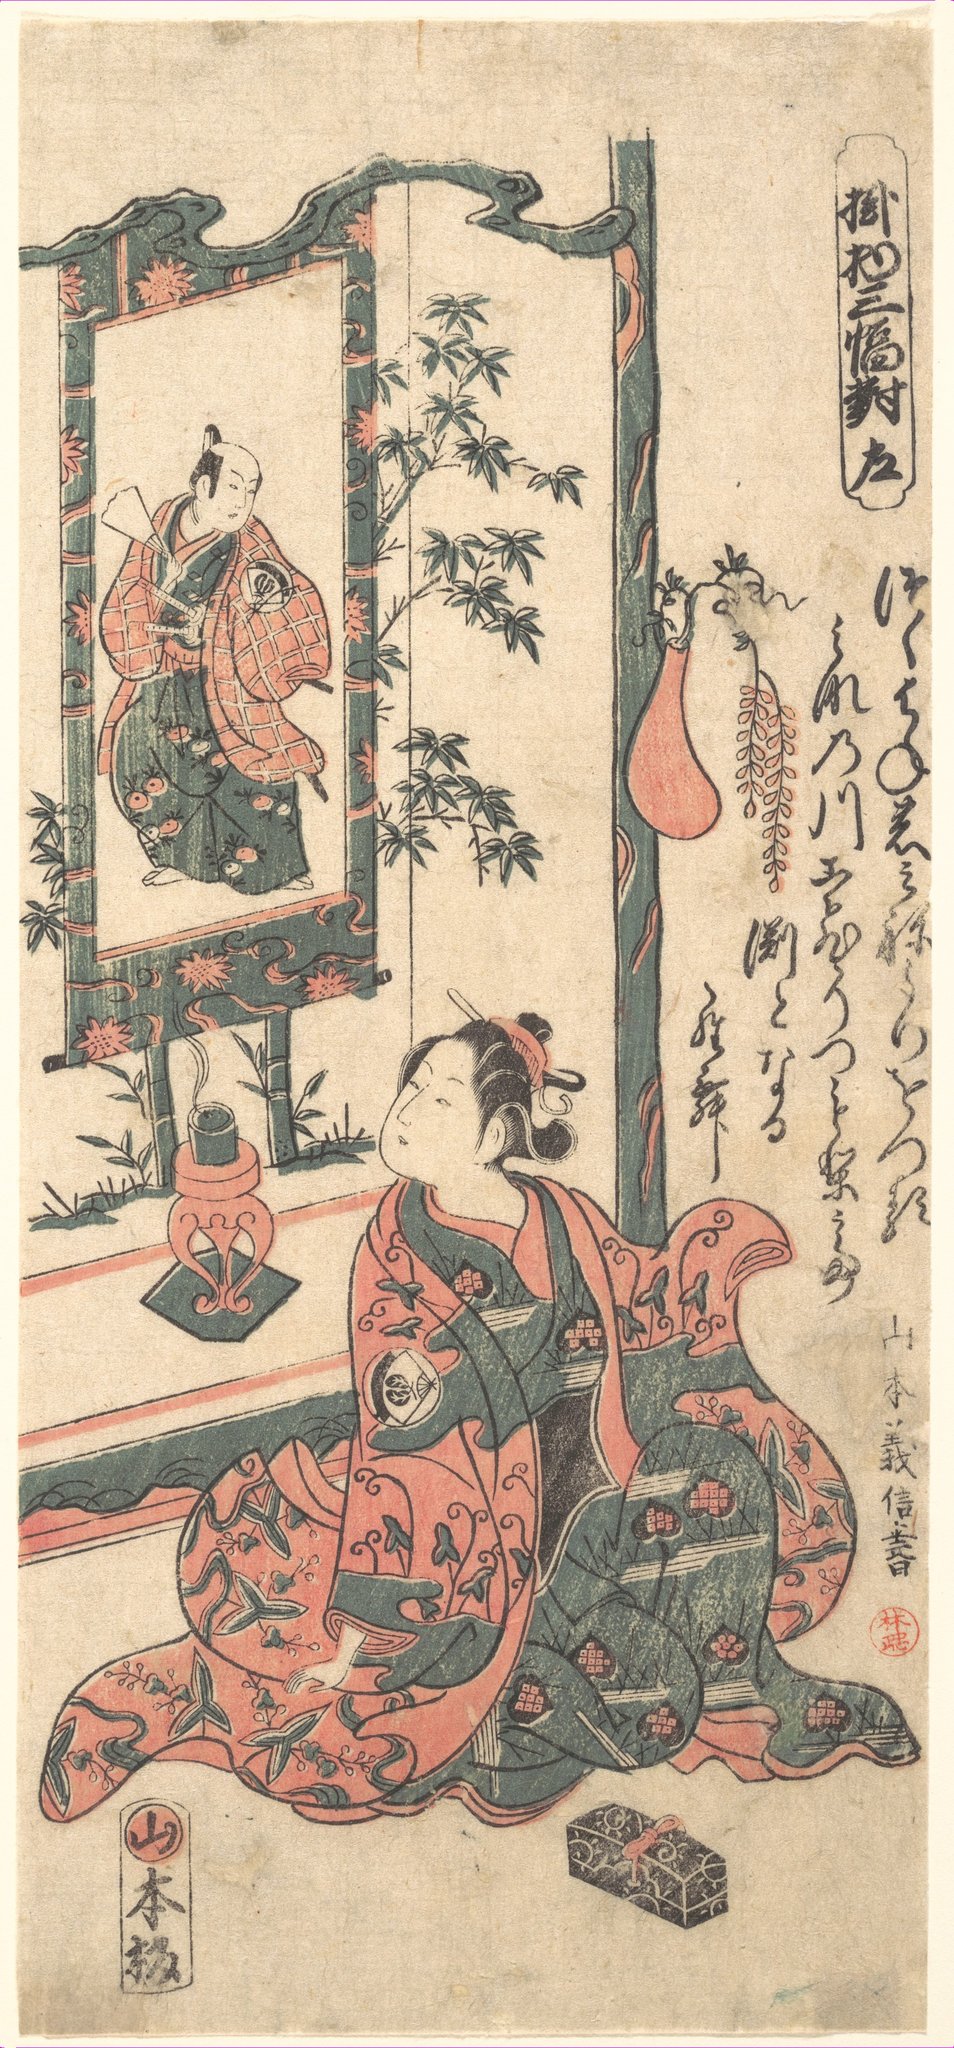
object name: print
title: Kabuki Actor Onoe Kikugorō I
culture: japanese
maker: yamamoto yoshinobu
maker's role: artist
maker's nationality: japanese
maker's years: 1745-1758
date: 1750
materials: ink, paper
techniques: woodblock print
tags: men,women,actors